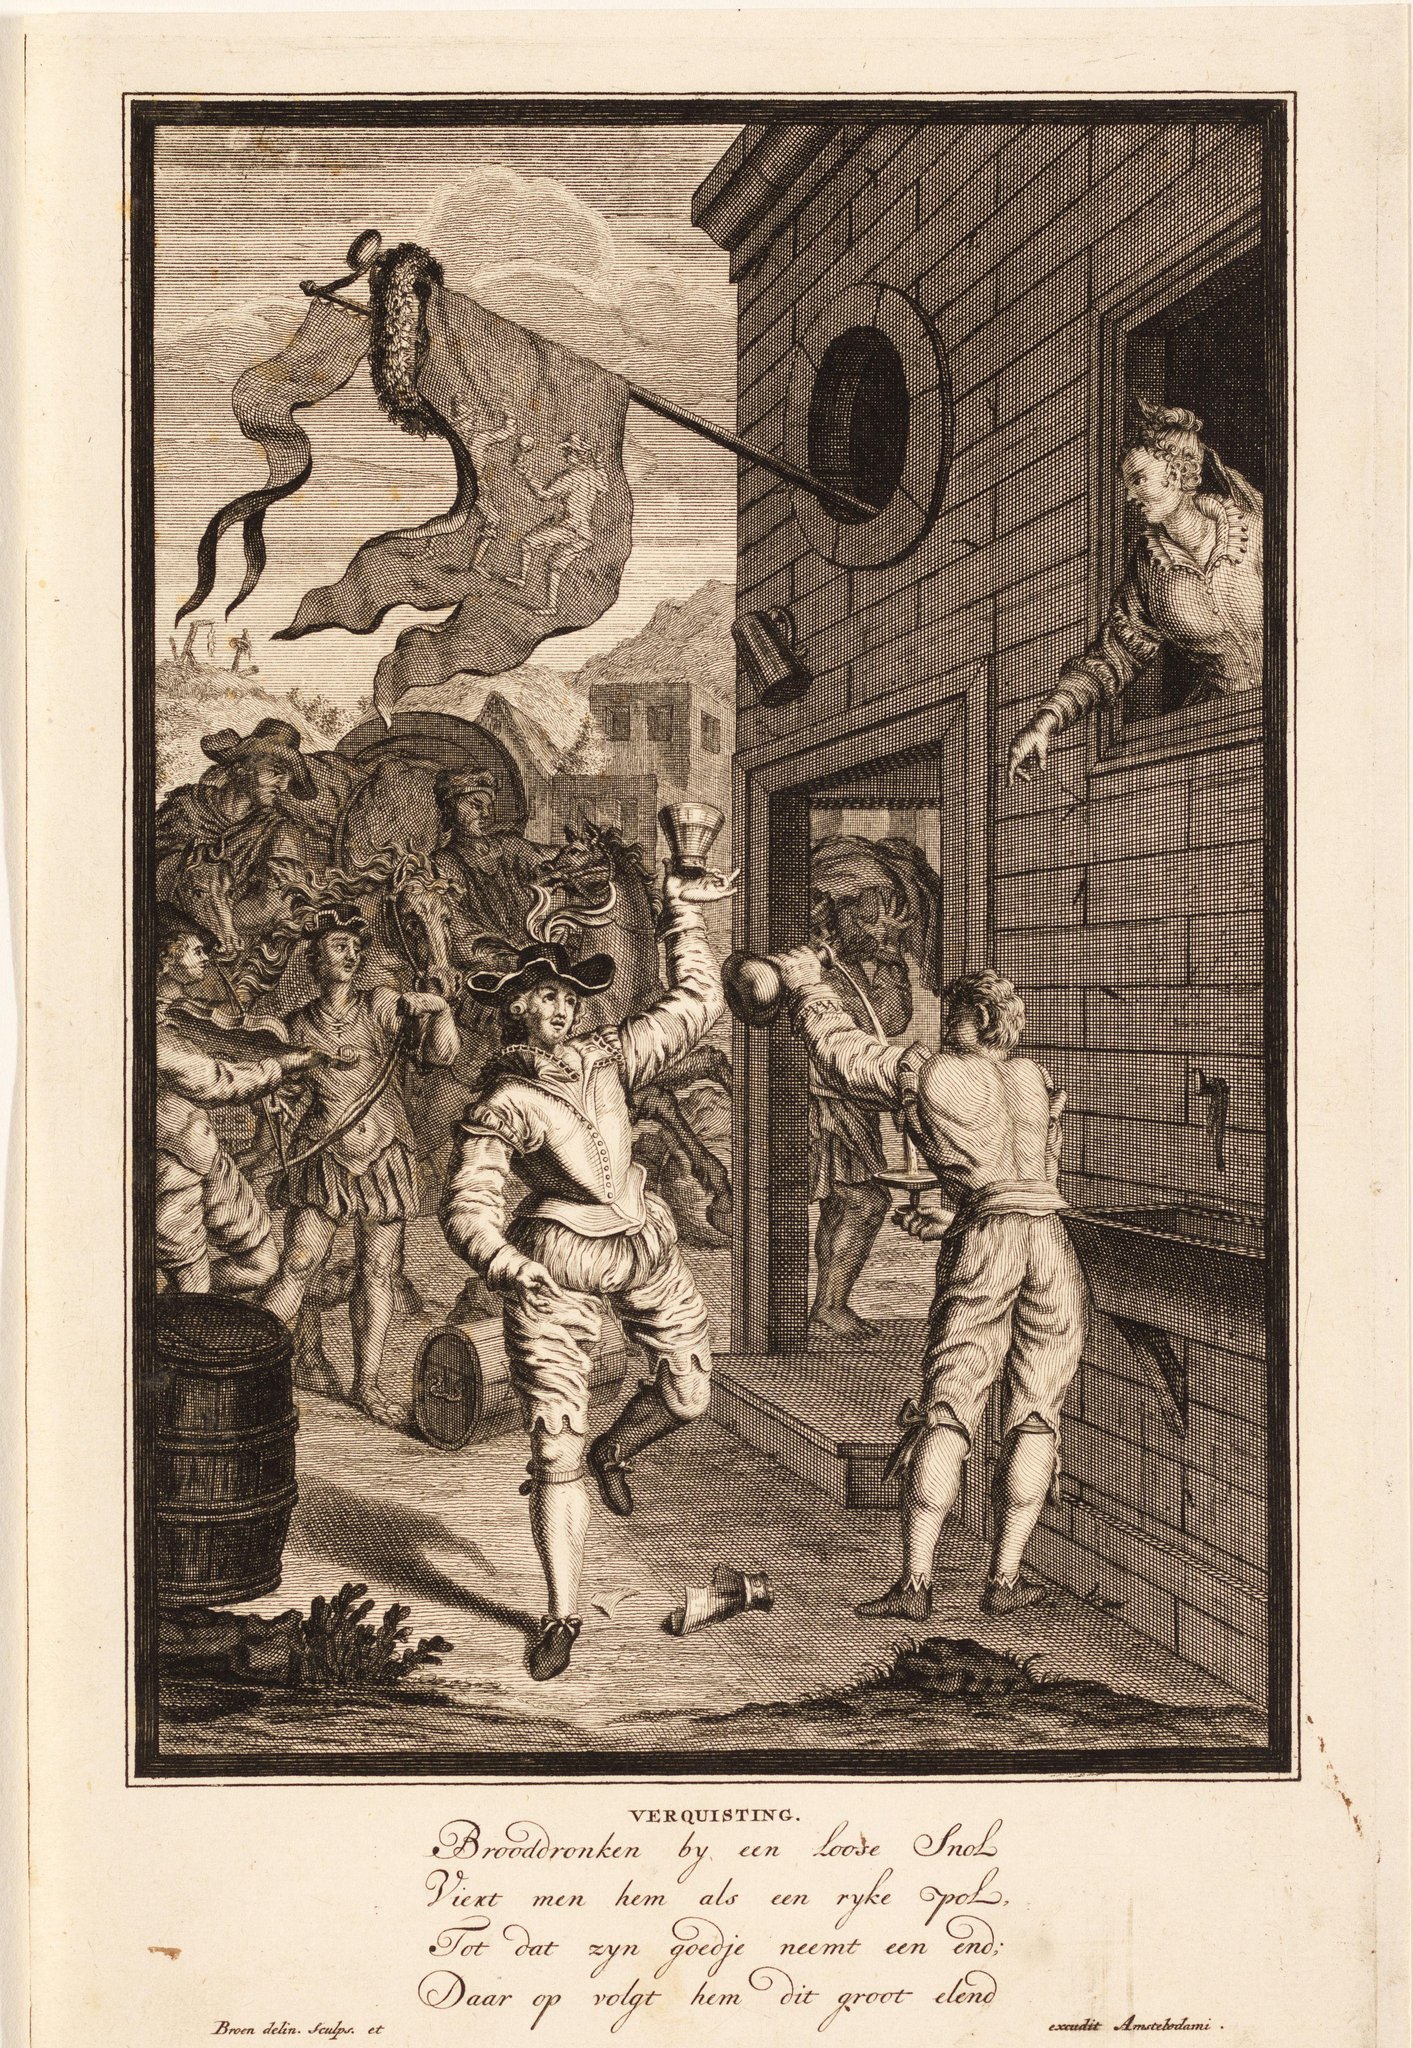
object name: print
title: Verquisting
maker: gerrit de broen (i)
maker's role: print maker, publisher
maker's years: 1659-1740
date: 1684-1740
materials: paper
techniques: engraving, etching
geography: amsterdam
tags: the parable of the prodigal son (luke 15:11-32)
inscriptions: collector's mark: Lugt 2228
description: De verloren zoon danst uitbundig voor een kroeg in een stad. Hij houdt een glas in zijn handen en proost een jonge vrouw die uit het raam van de kroeg kijkt toe. Hij gedraagt zich als een rijke man maar zijn erfdeel is bijna op. Onder de voorstelling een Nederlands vers over het verhaal.